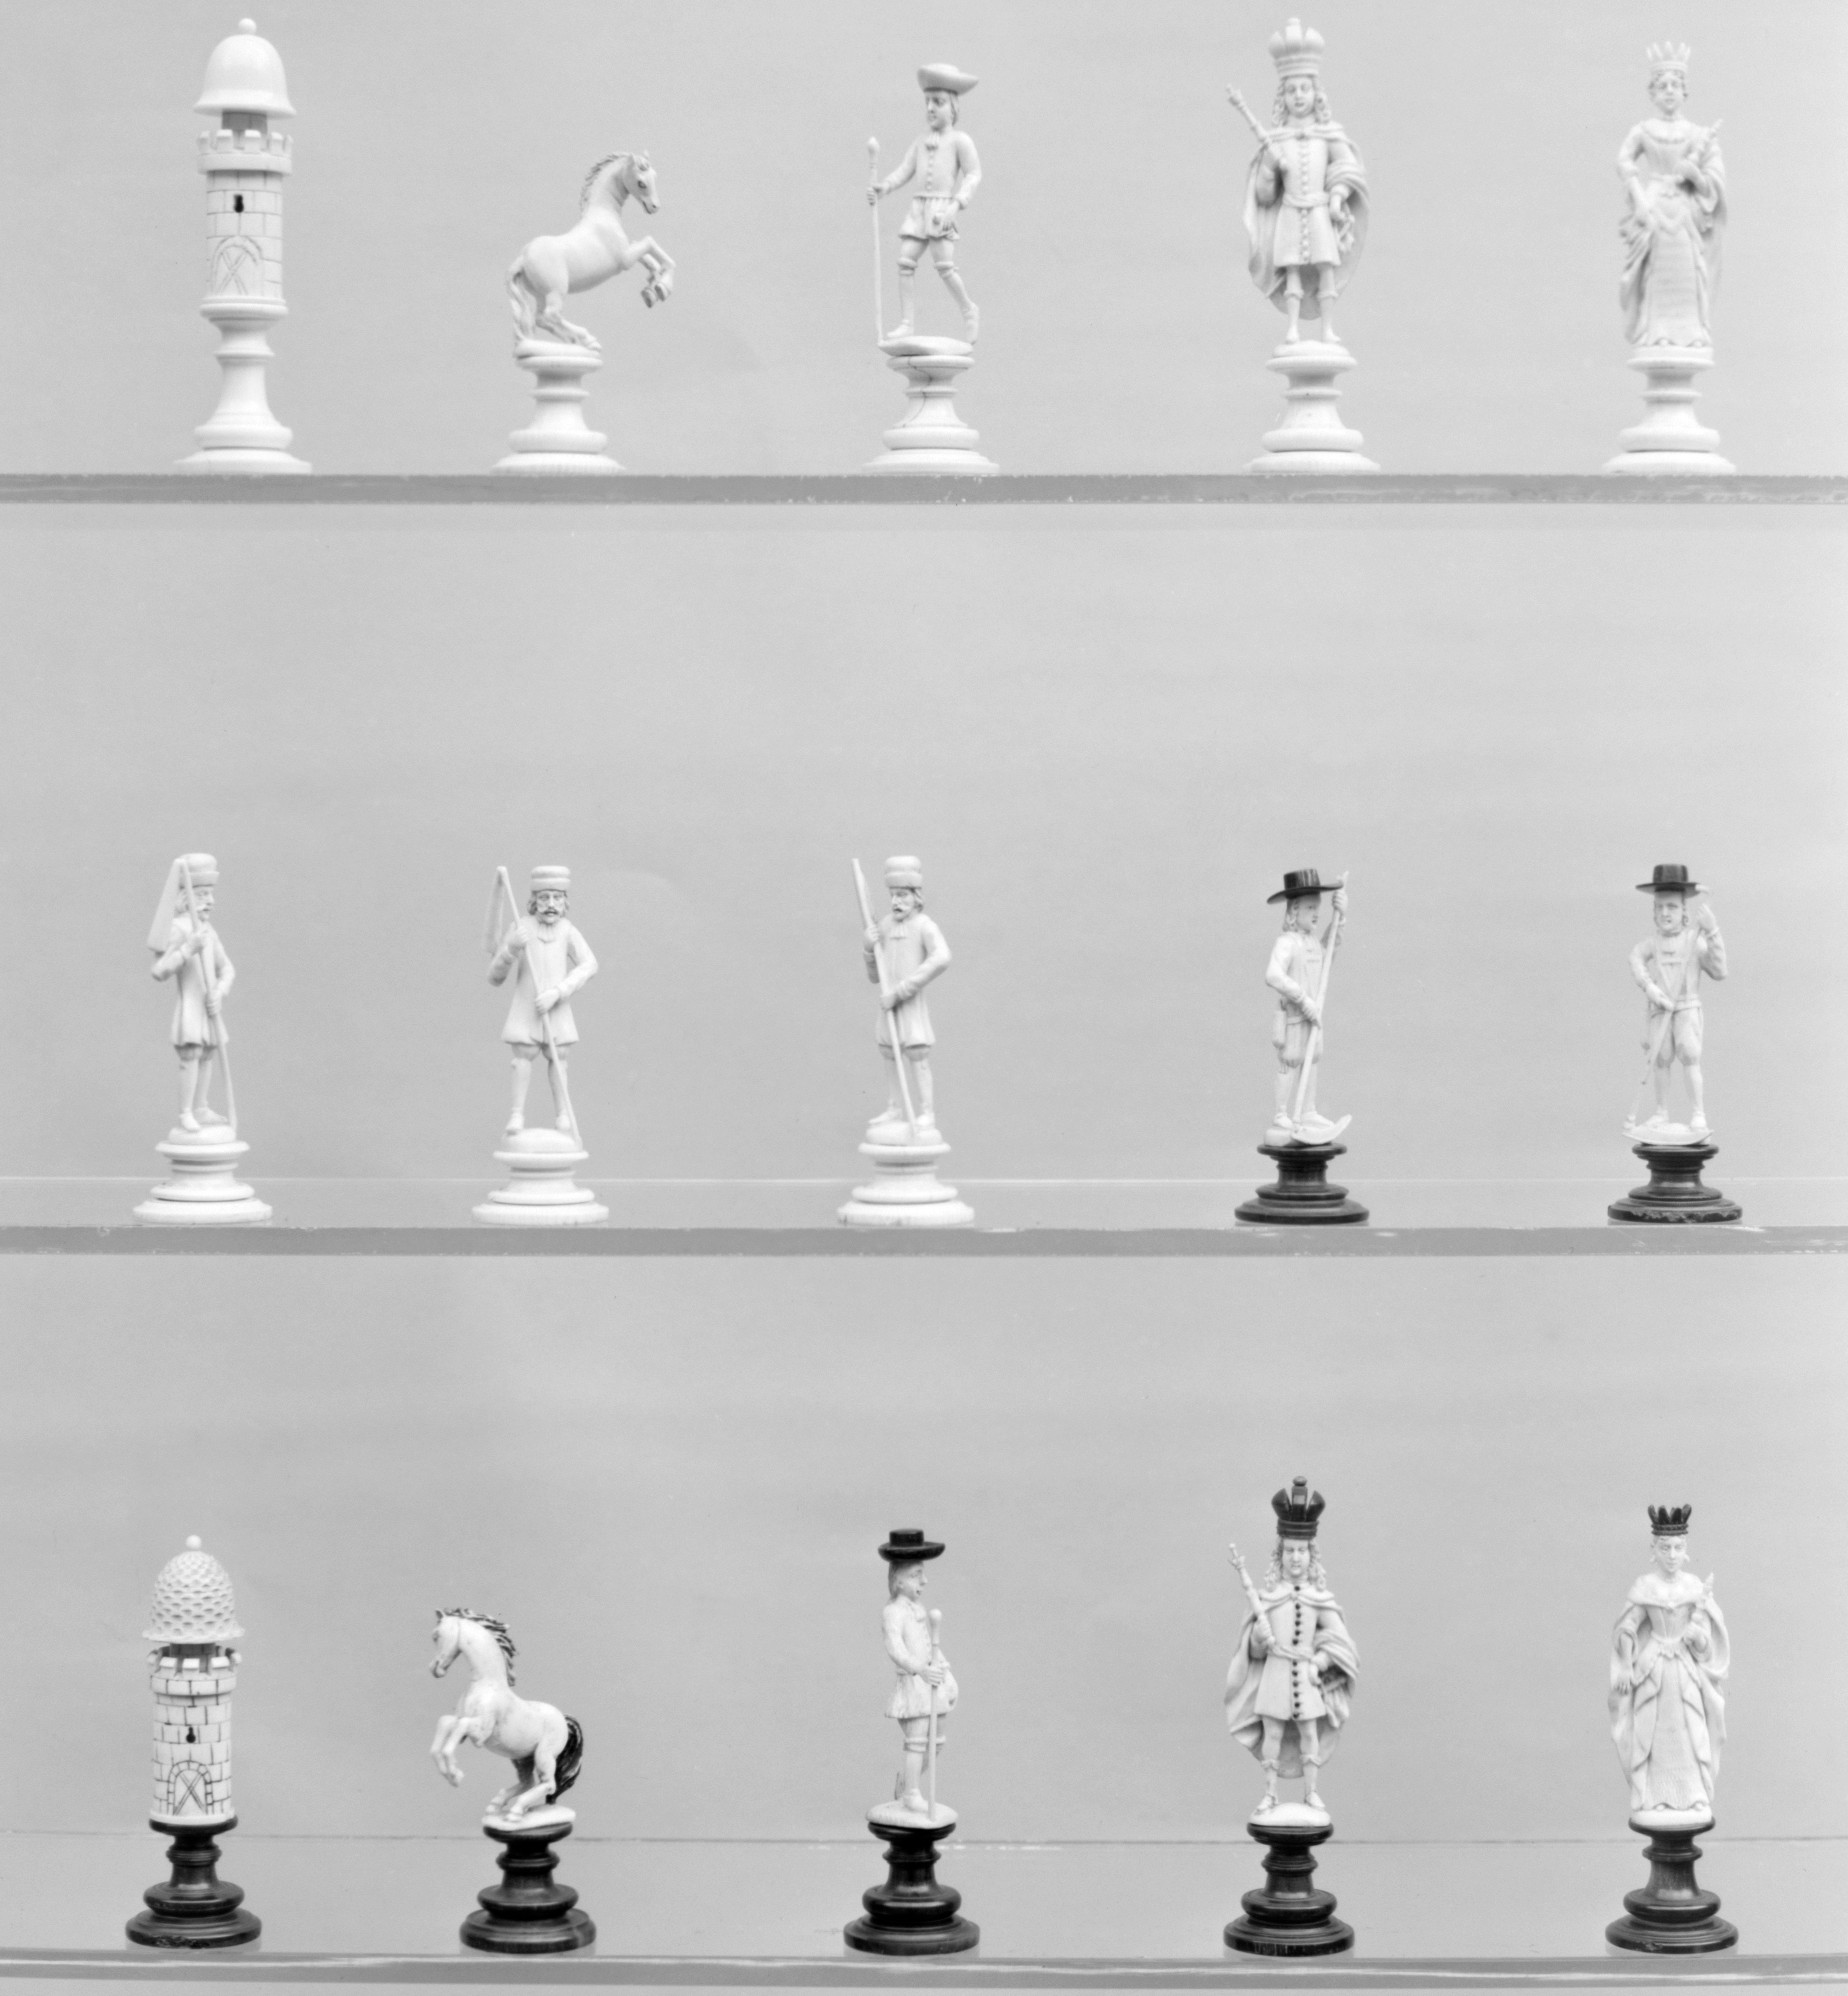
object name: chessman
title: Chessmen (29)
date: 1820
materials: horn, ivory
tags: chess,games